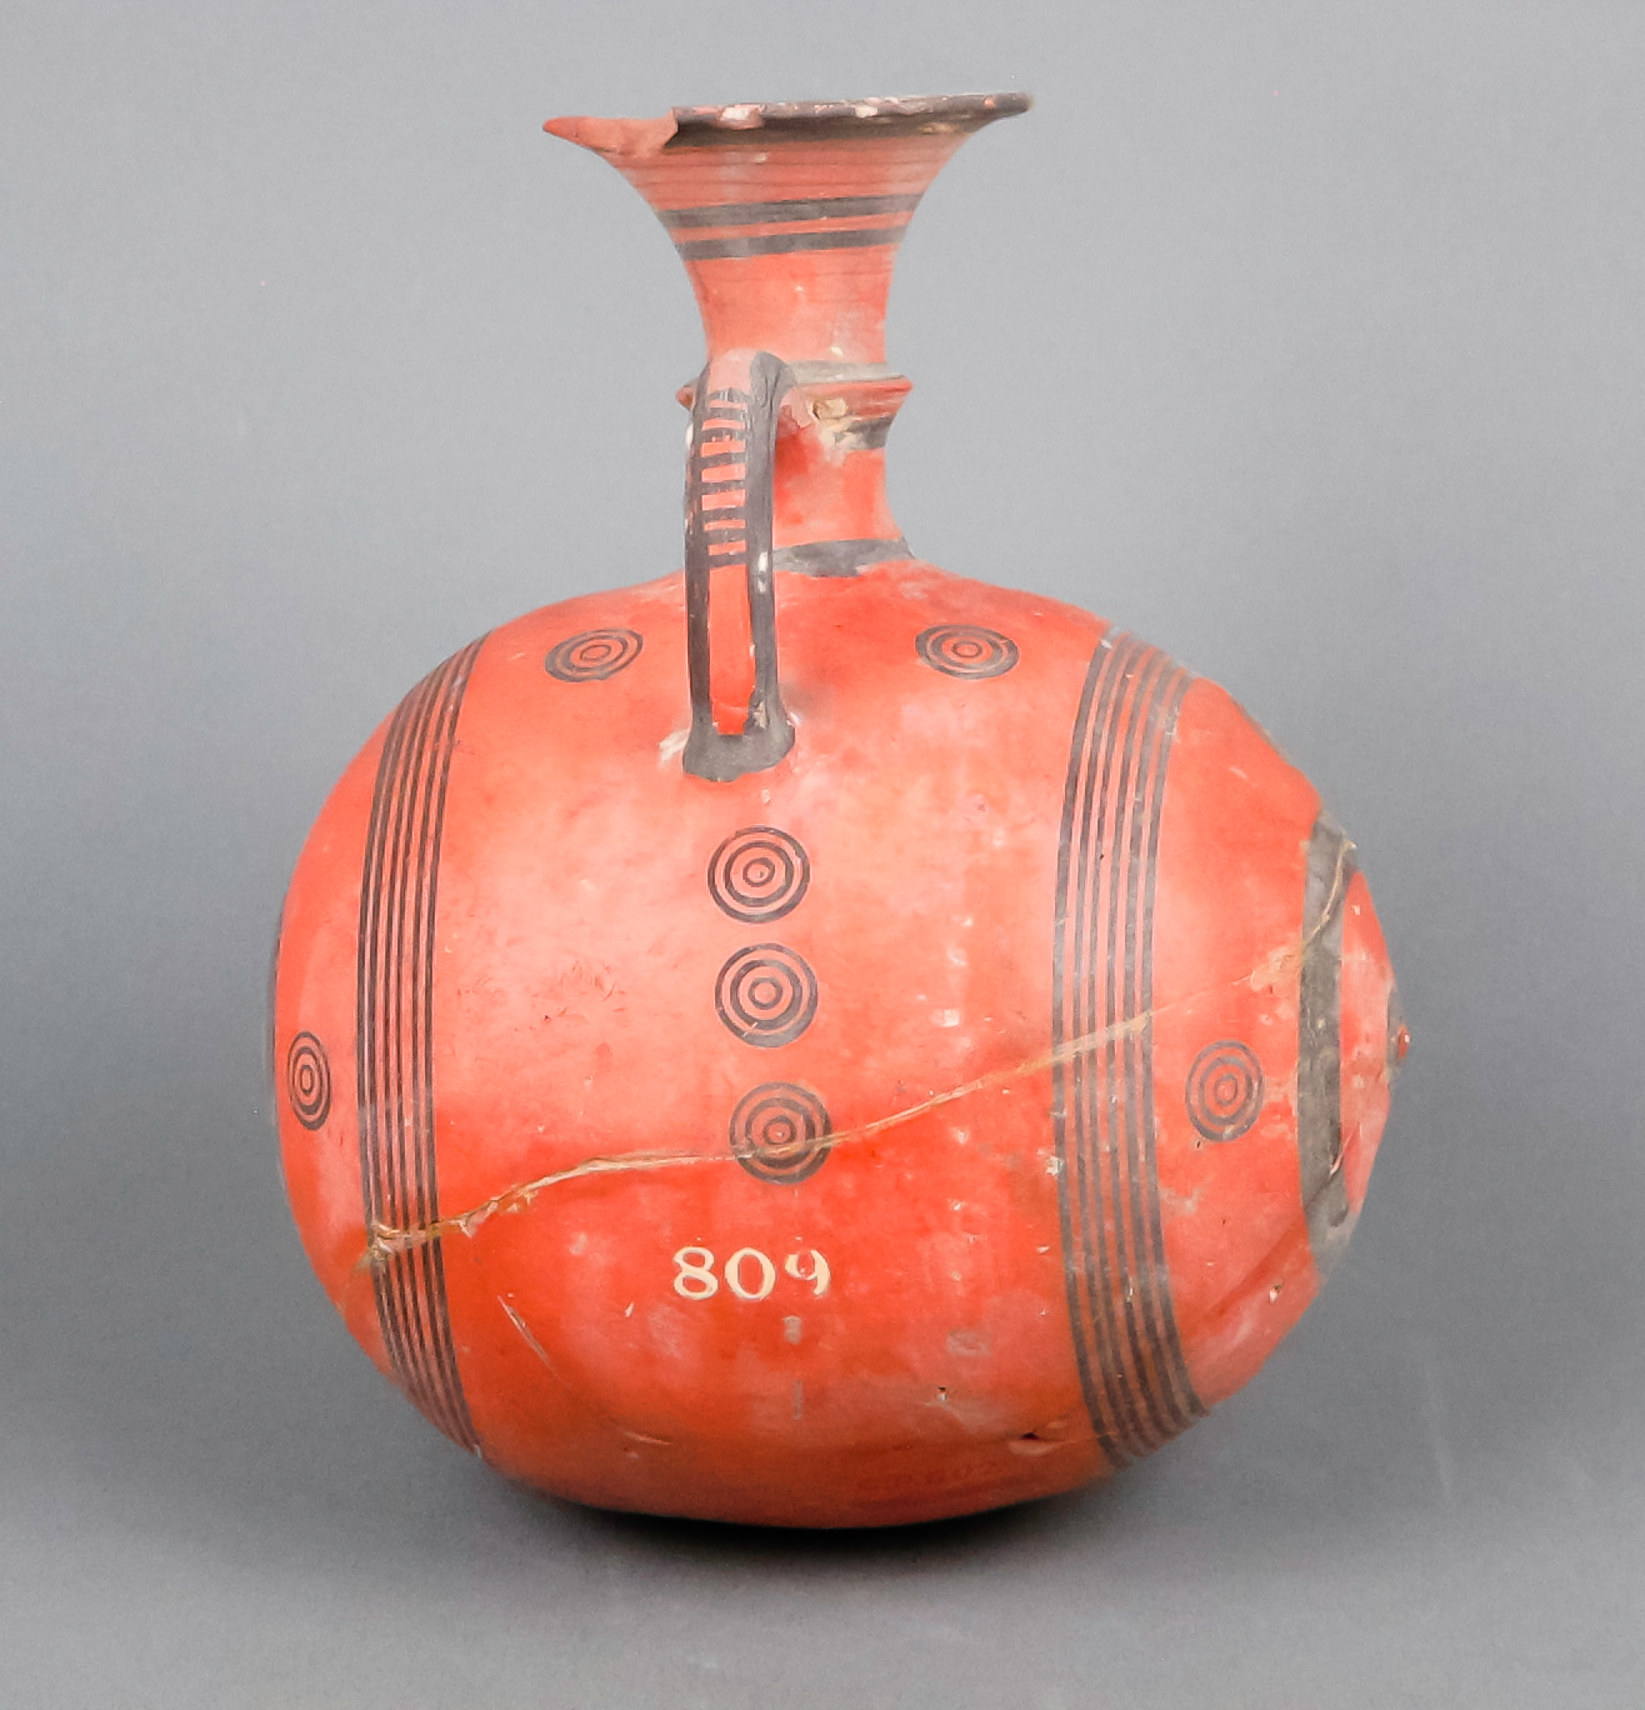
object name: jug, barrel shaped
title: Jug, barrel-shaped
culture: cypriot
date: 850-750 BCE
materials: terracotta